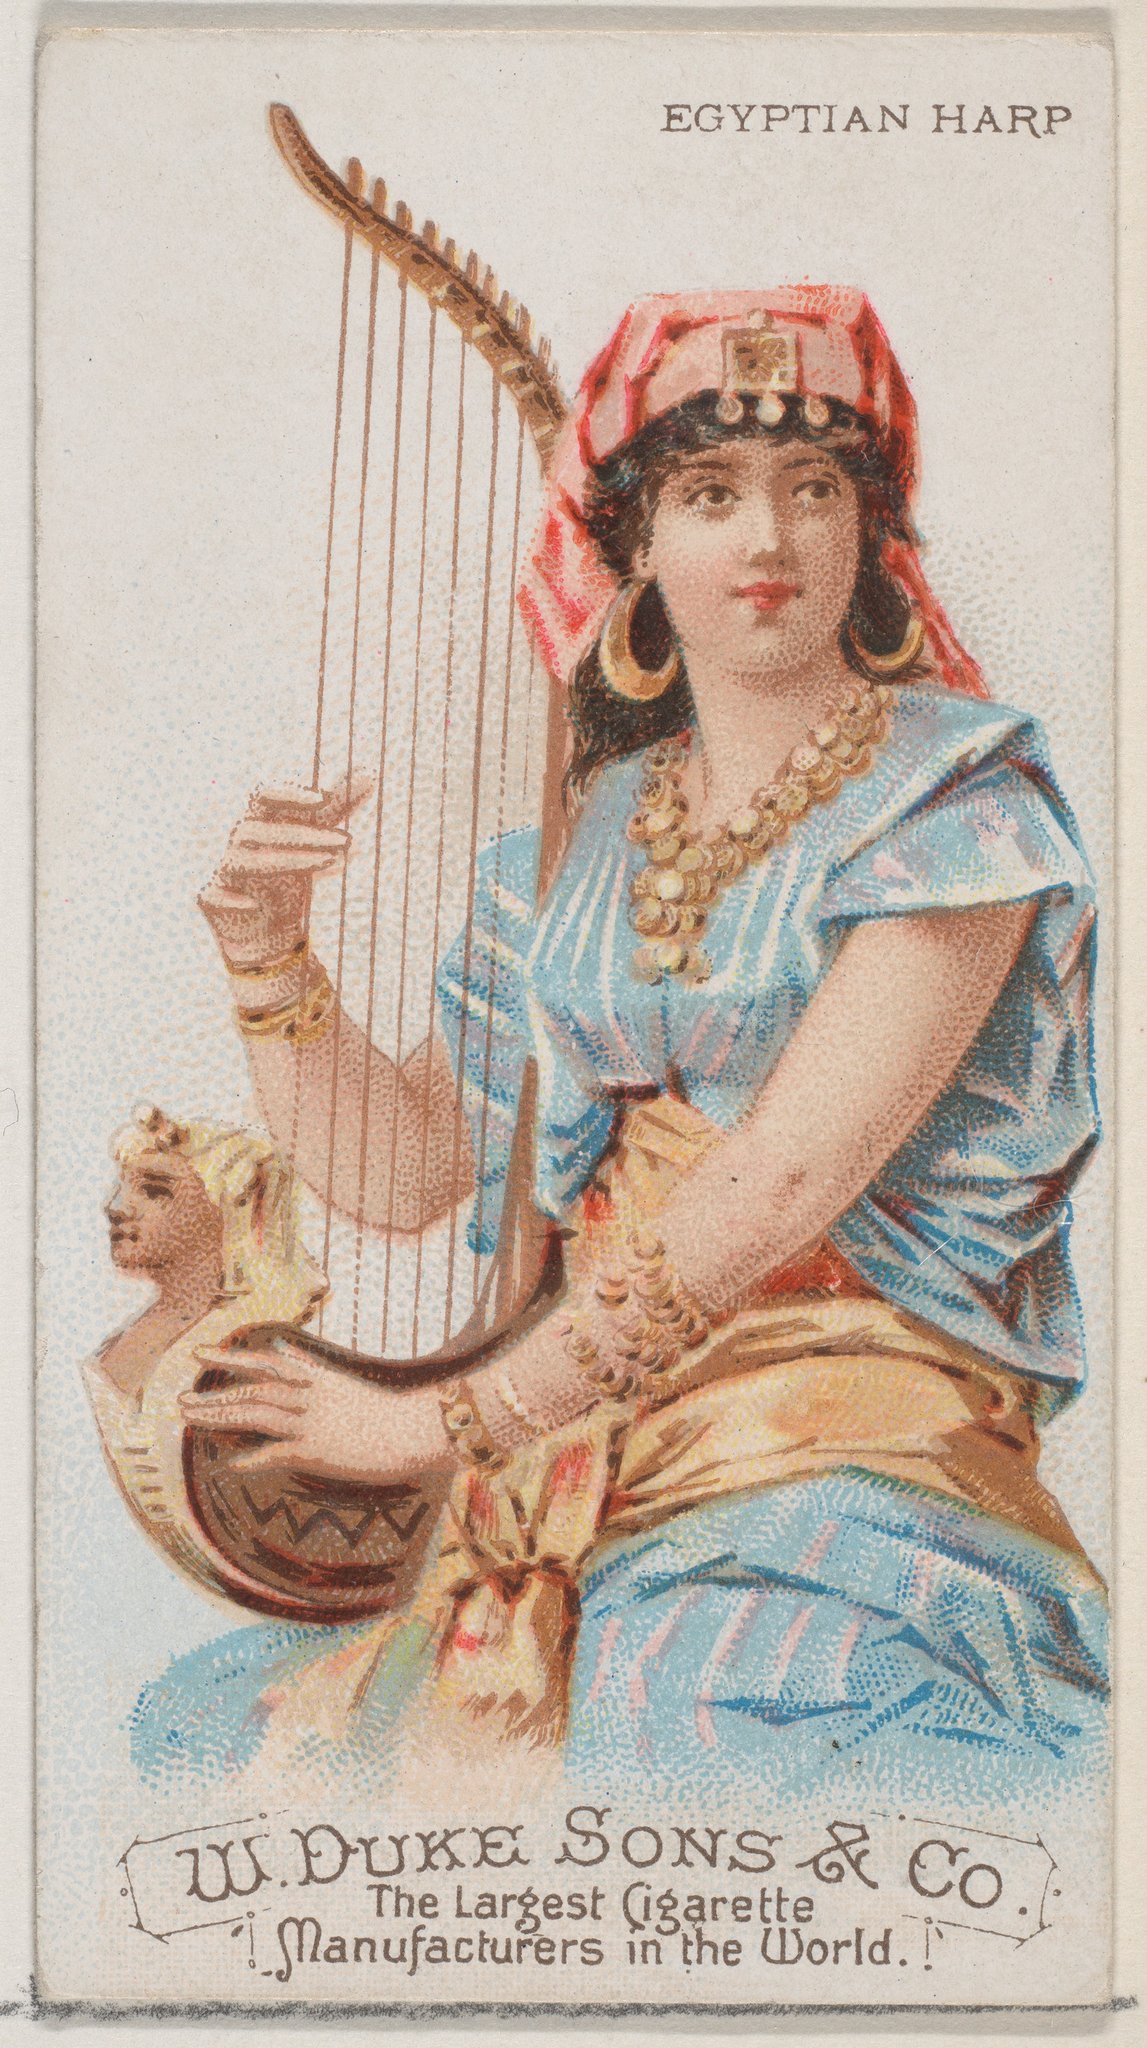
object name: print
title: Egyptian Harp, from the Musical Instruments series (N82) for Duke brand cigarettes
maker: w. duke, sons & co.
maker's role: publisher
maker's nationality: american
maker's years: 1870-1920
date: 1888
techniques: color lithograph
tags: women,harps,musicians